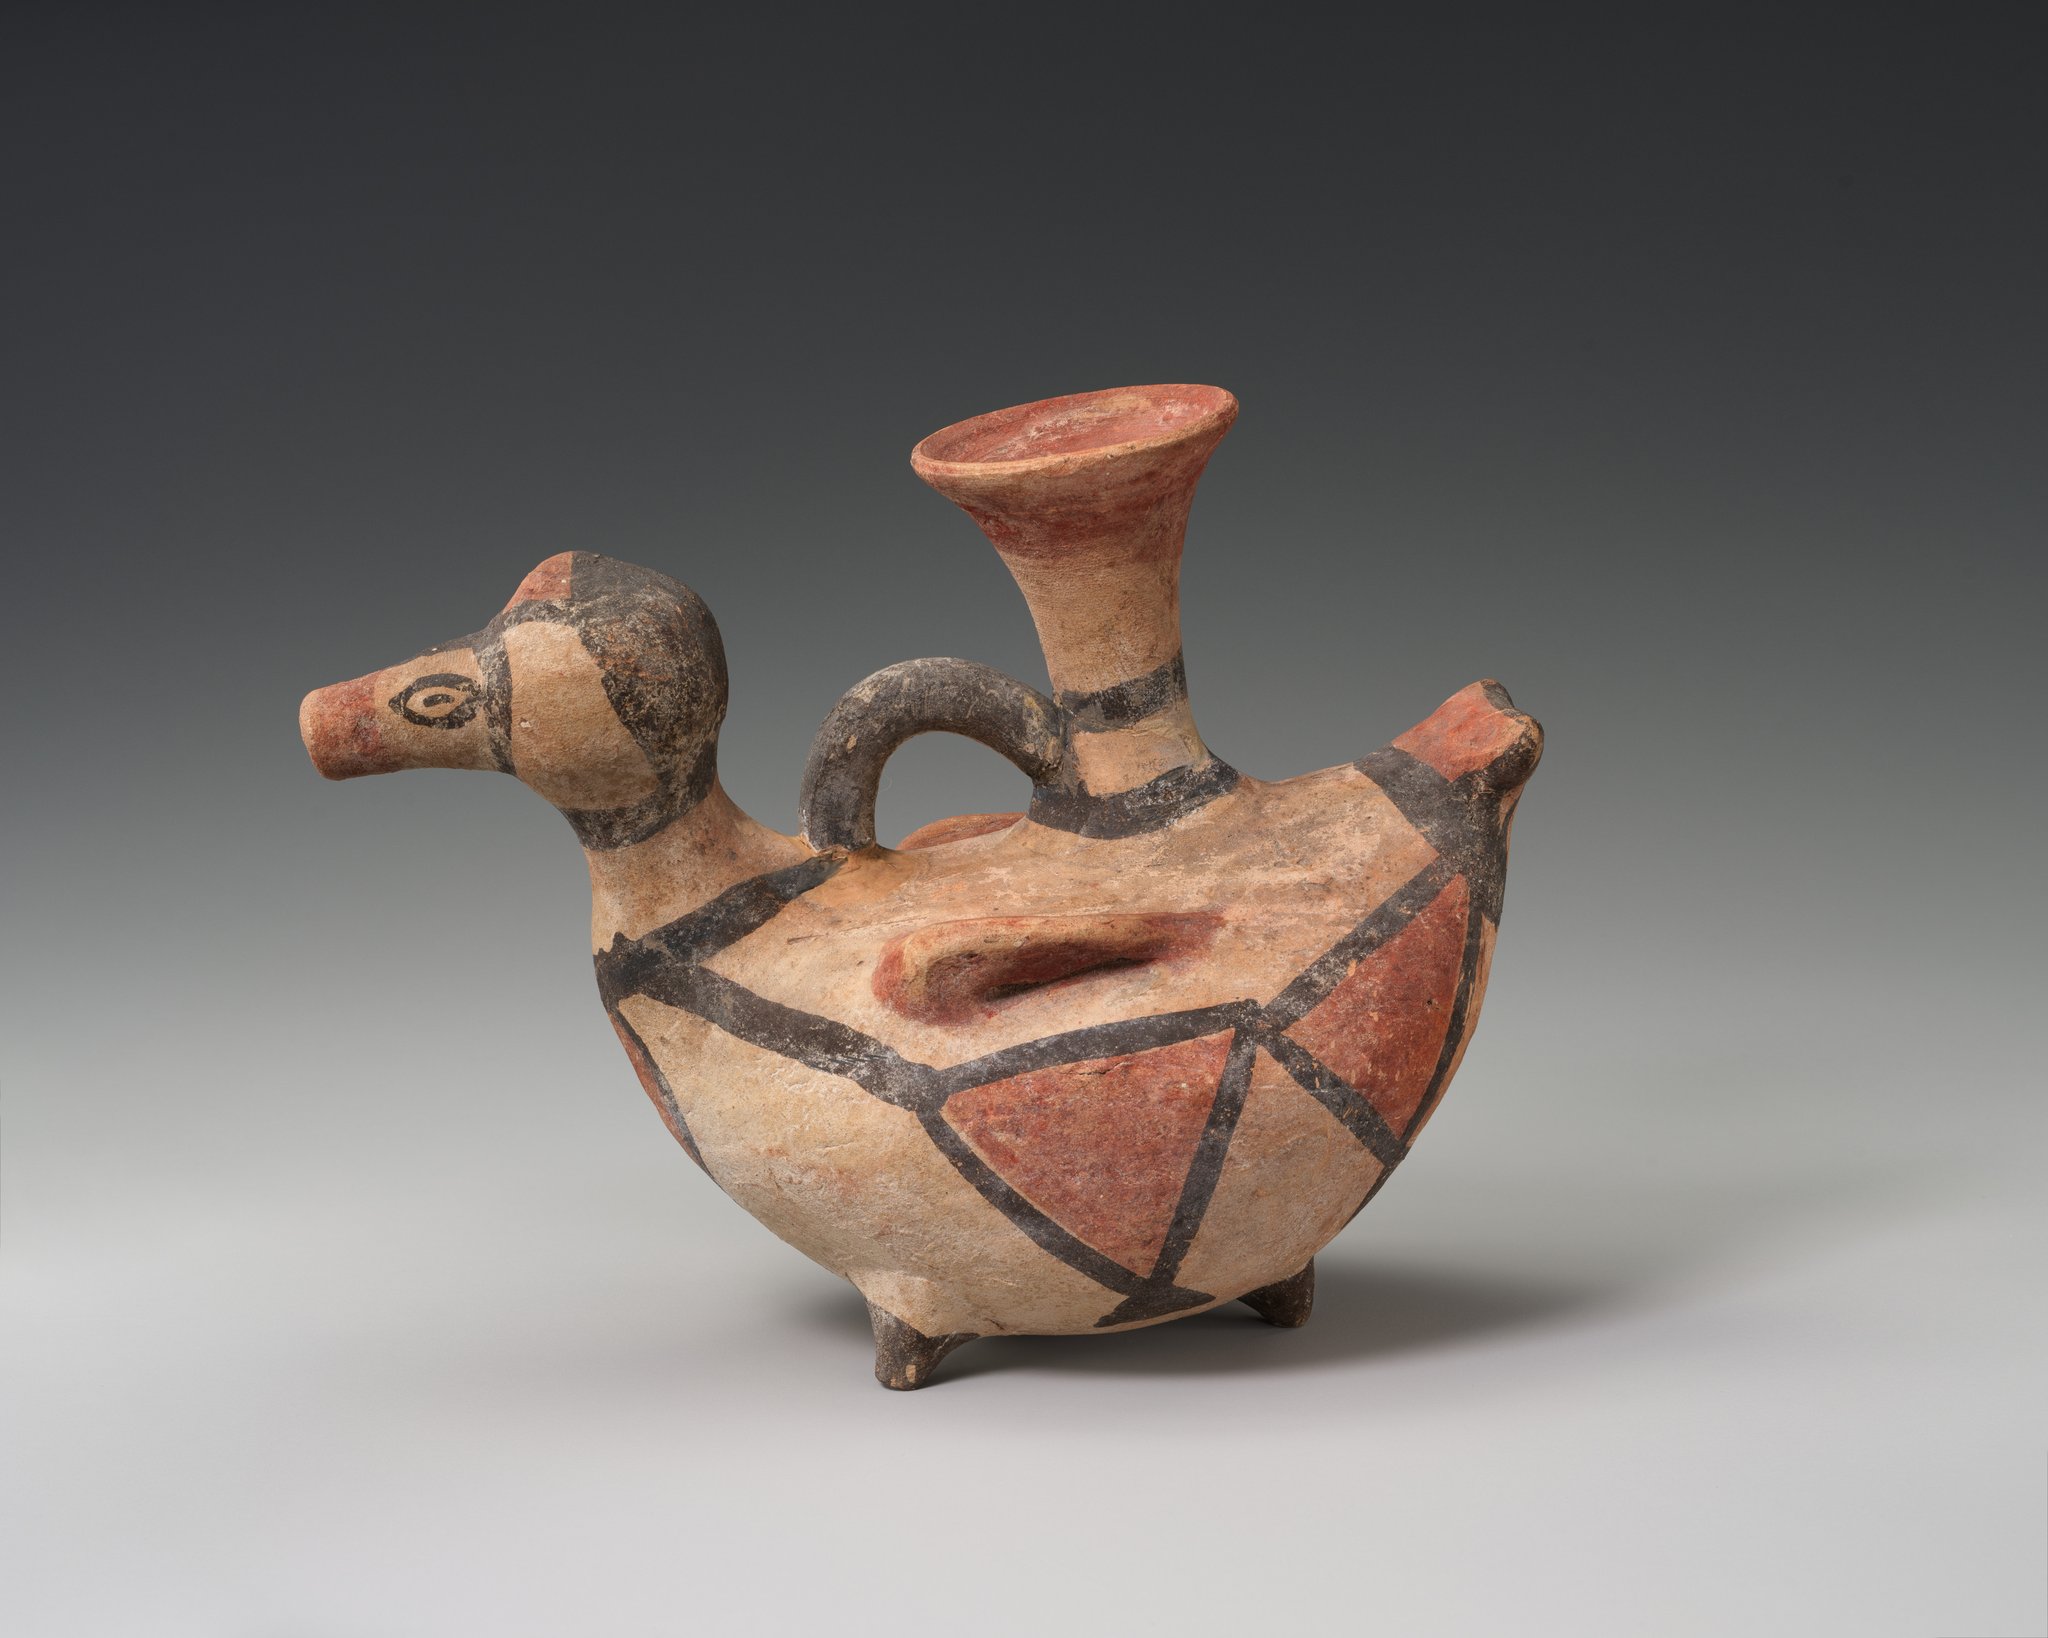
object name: askos in the form of a bird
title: Terracotta bird-shaped vase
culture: cypriot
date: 850-750 BCE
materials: terracotta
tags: birds